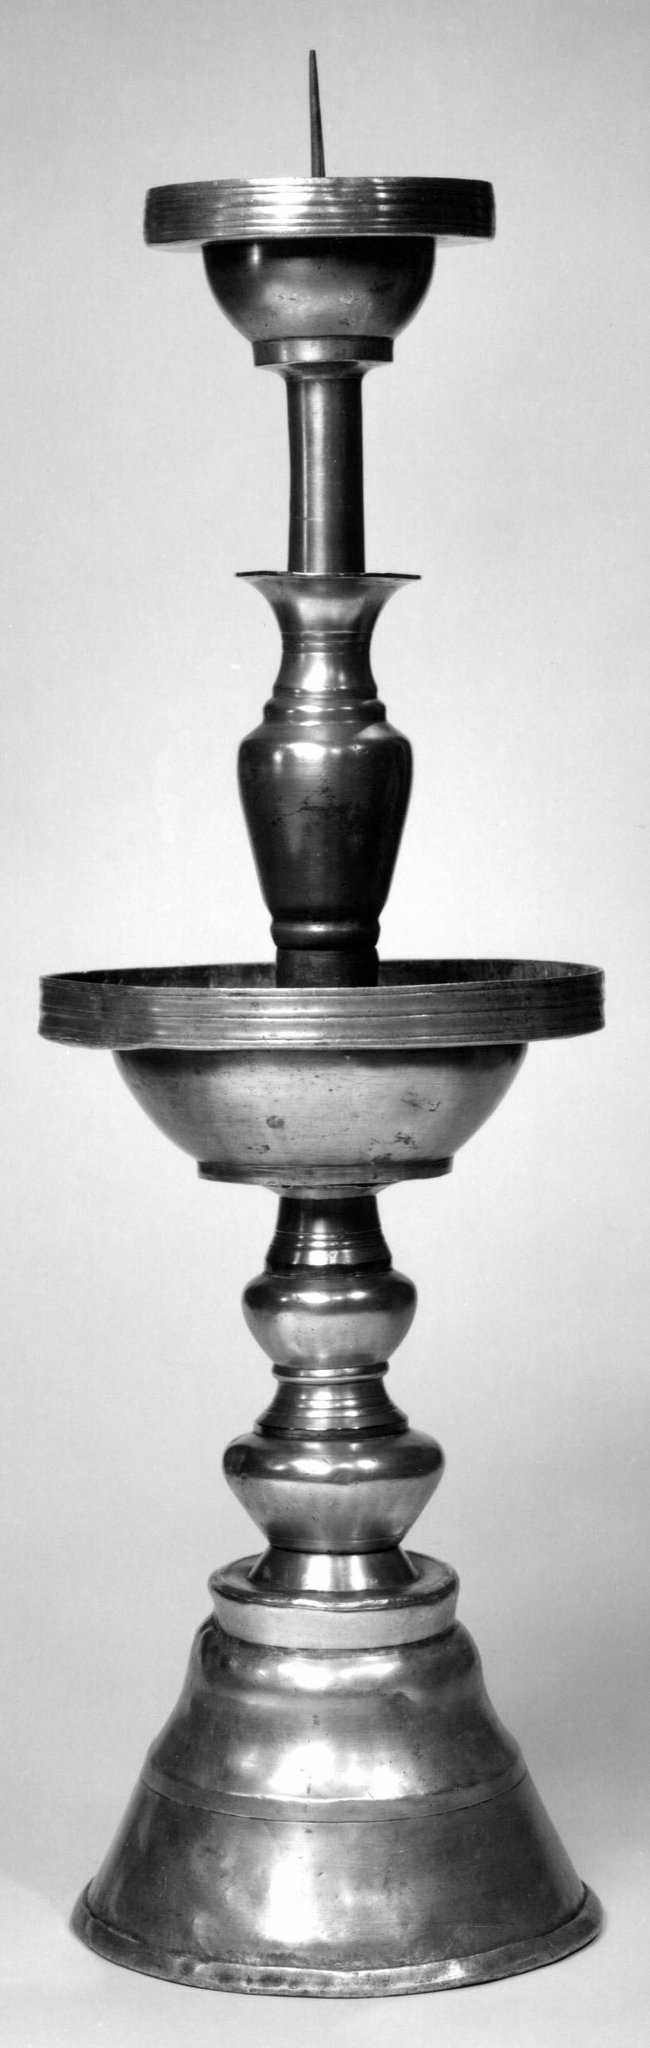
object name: candlestick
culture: chinese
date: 1601-1700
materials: pewter